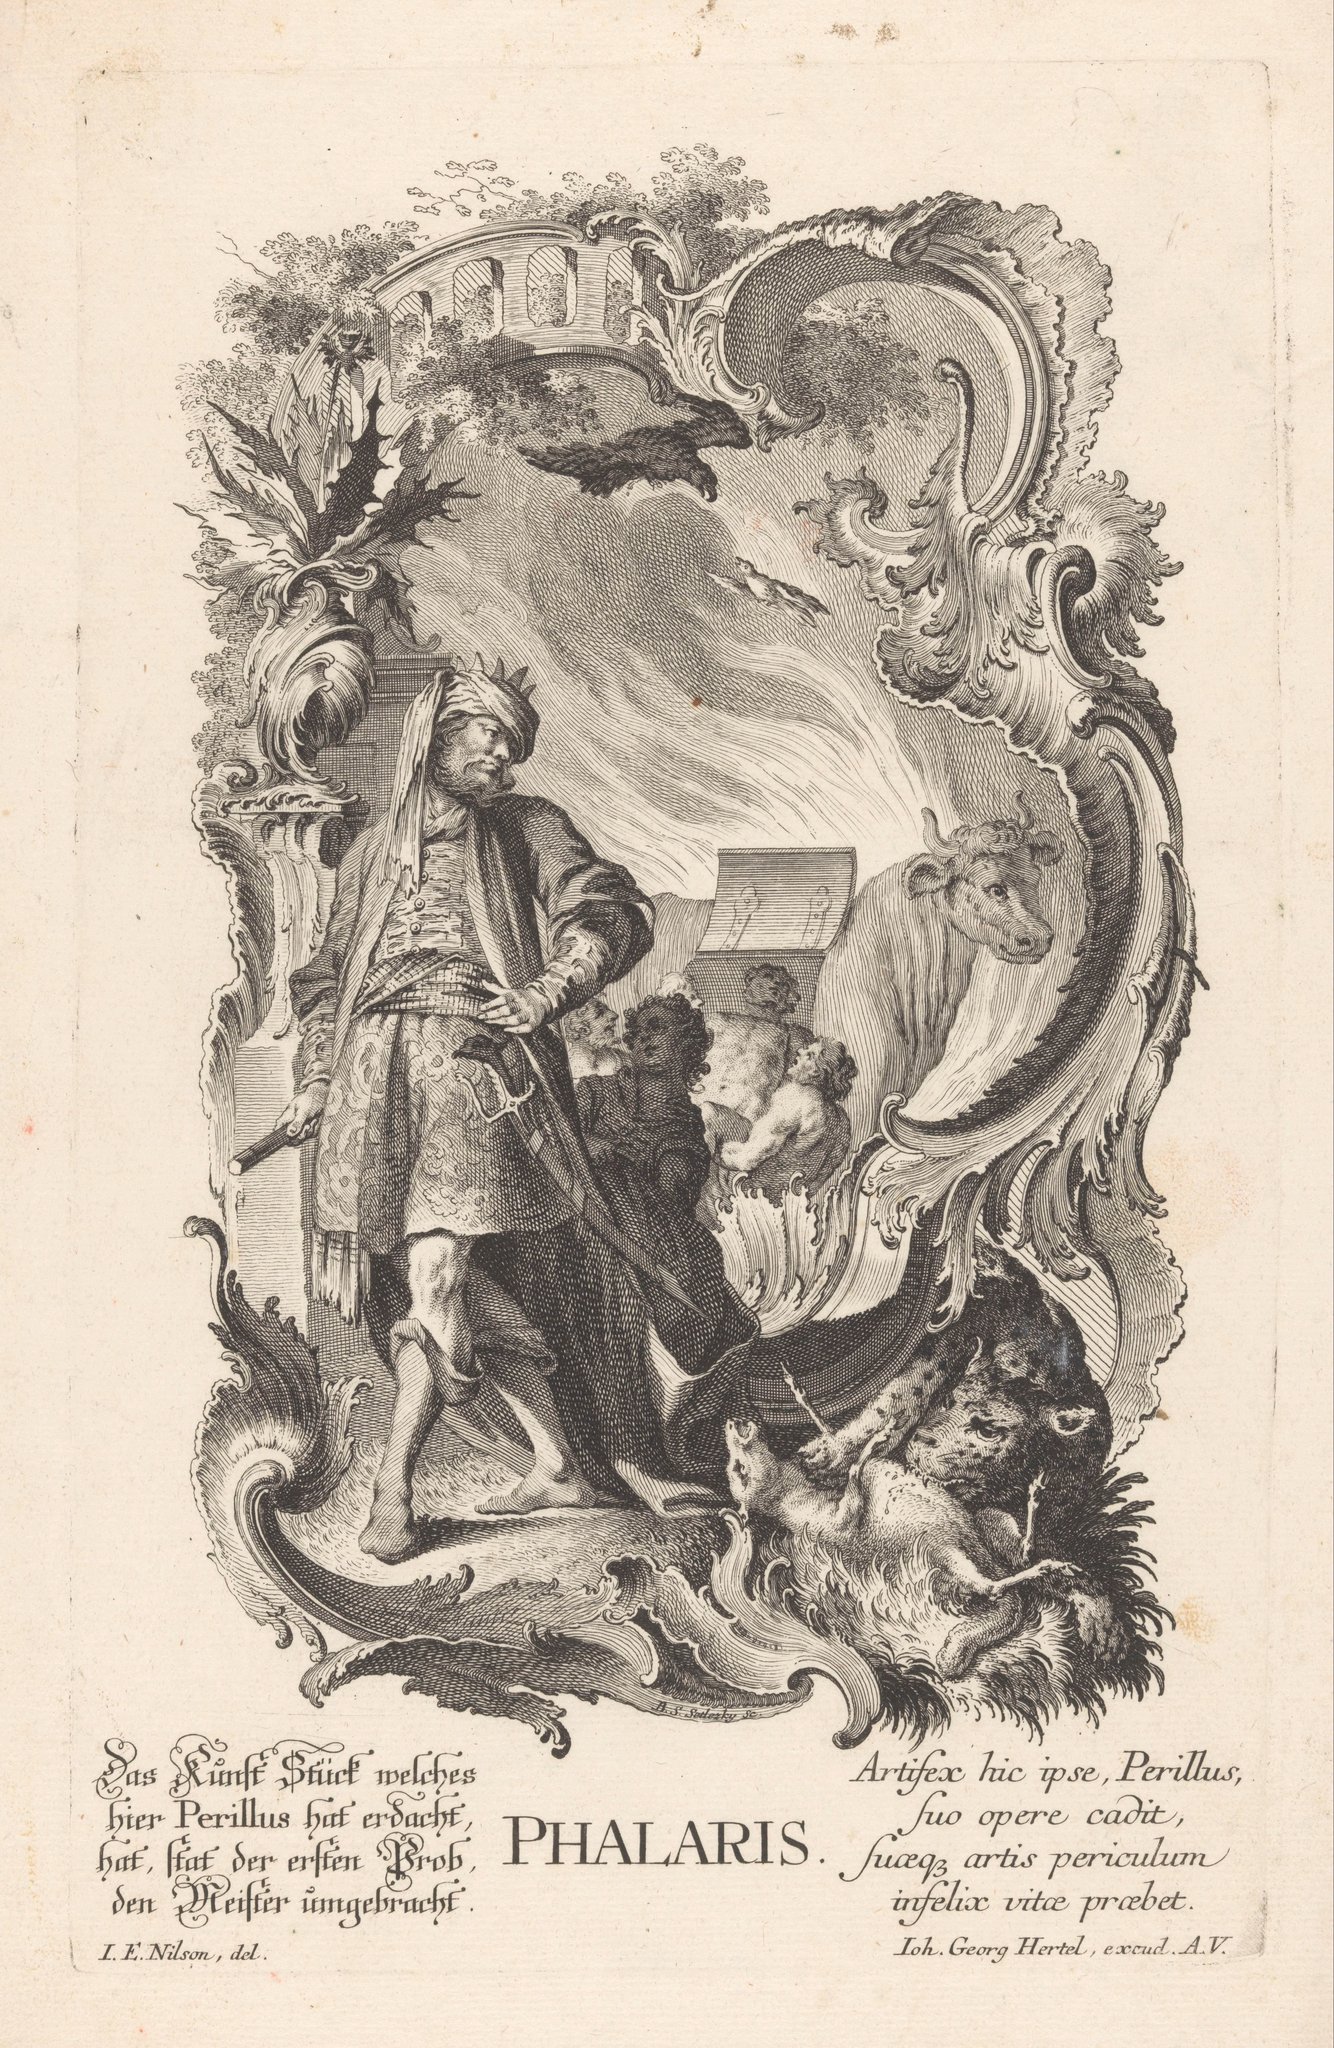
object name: ornament print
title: Falaris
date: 1731-1771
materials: paper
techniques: engraving, etching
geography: augsburg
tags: beasts of prey, predatory animals: leopard, (story of) phalaris, tyrant of agrigentum, death of perillus: he is thrown into a heated bronze bull by order of phalaris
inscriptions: collector's mark: Lugt 2760, collector's mark: Lugt 2228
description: Koning Falaris staat links in de voorgrond en kijkt toe hoe Perillos in het martelwerktuig de messingen stier wordt gedragen. Rechts in de voorgrond bijt een panter zijn prooi. Rondom de voorstelling een rocaille omlijsting met vaas. In de ondermarge tweemaal een vierregelige Duitse en Latijnse tekst.